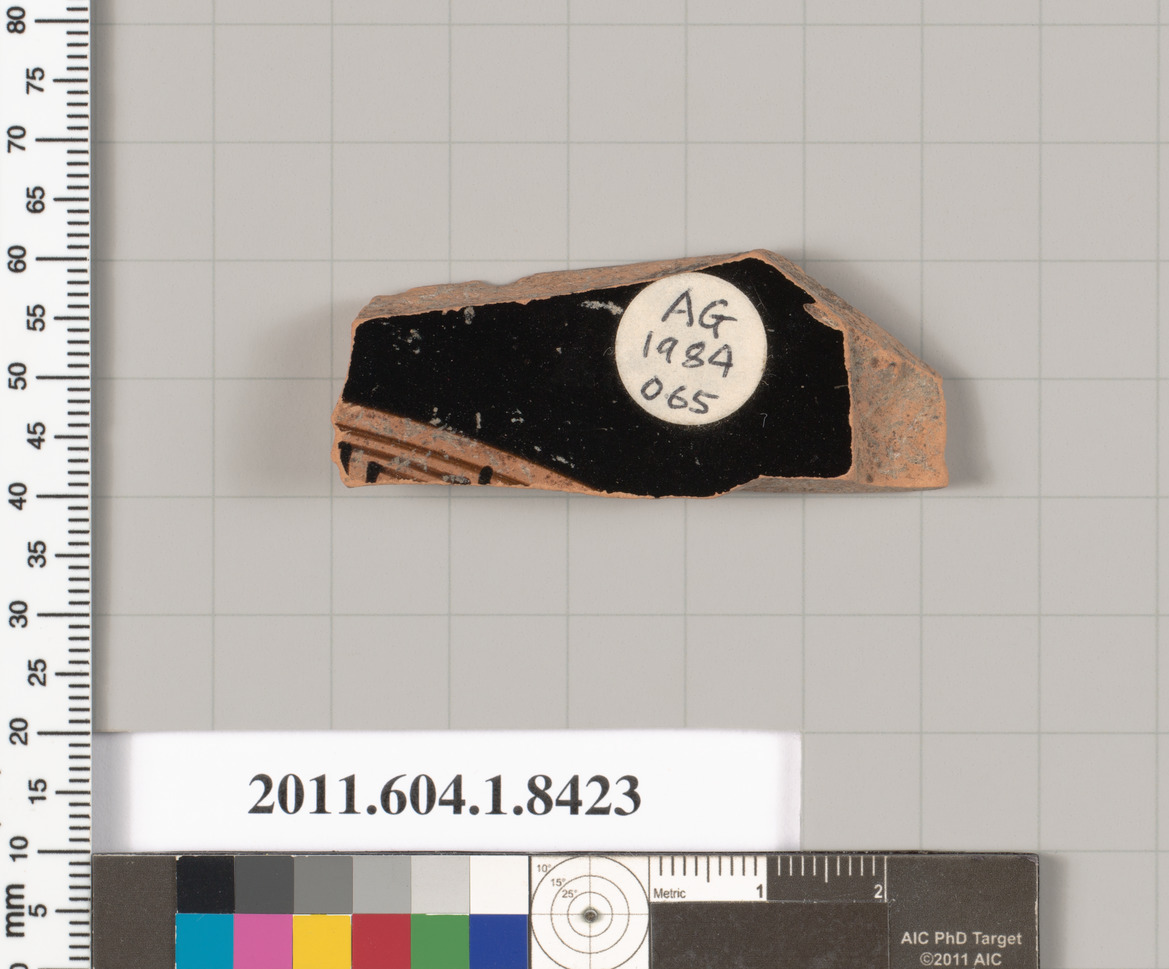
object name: kylix fragment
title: Terracotta fragment of a kylix (drinking cup)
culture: greek, attic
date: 434-401 BCE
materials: terracotta